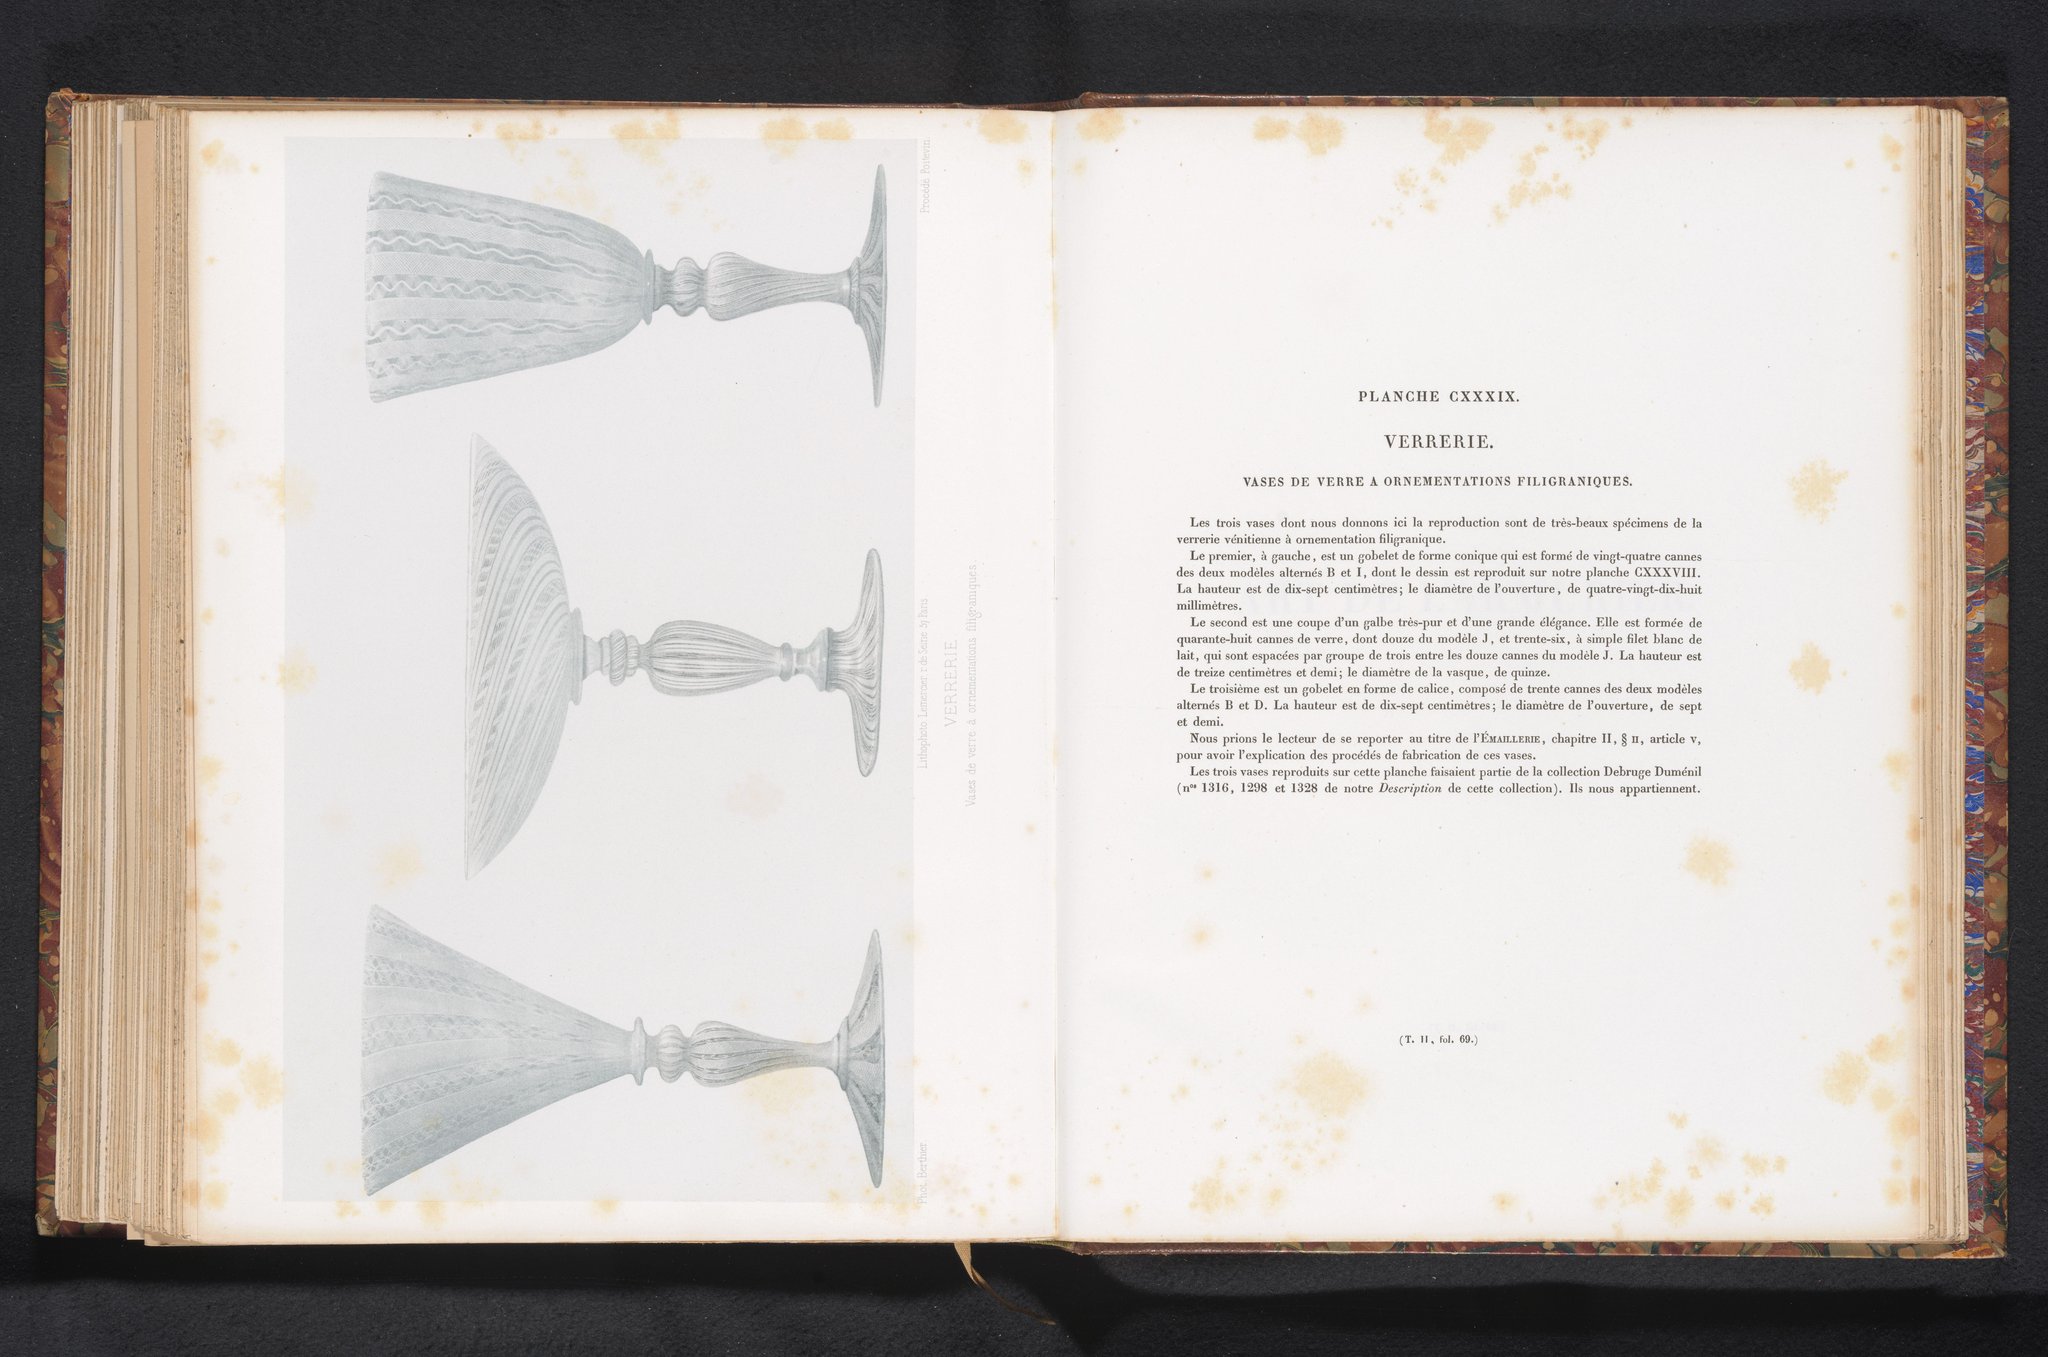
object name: reproduction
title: Vases de verre à ornementations filigraniques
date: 1859-1864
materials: paper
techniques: photolithography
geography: paris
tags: glass, rummer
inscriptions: name: ‘Phot. Berthier/ Procédé Poitevin’